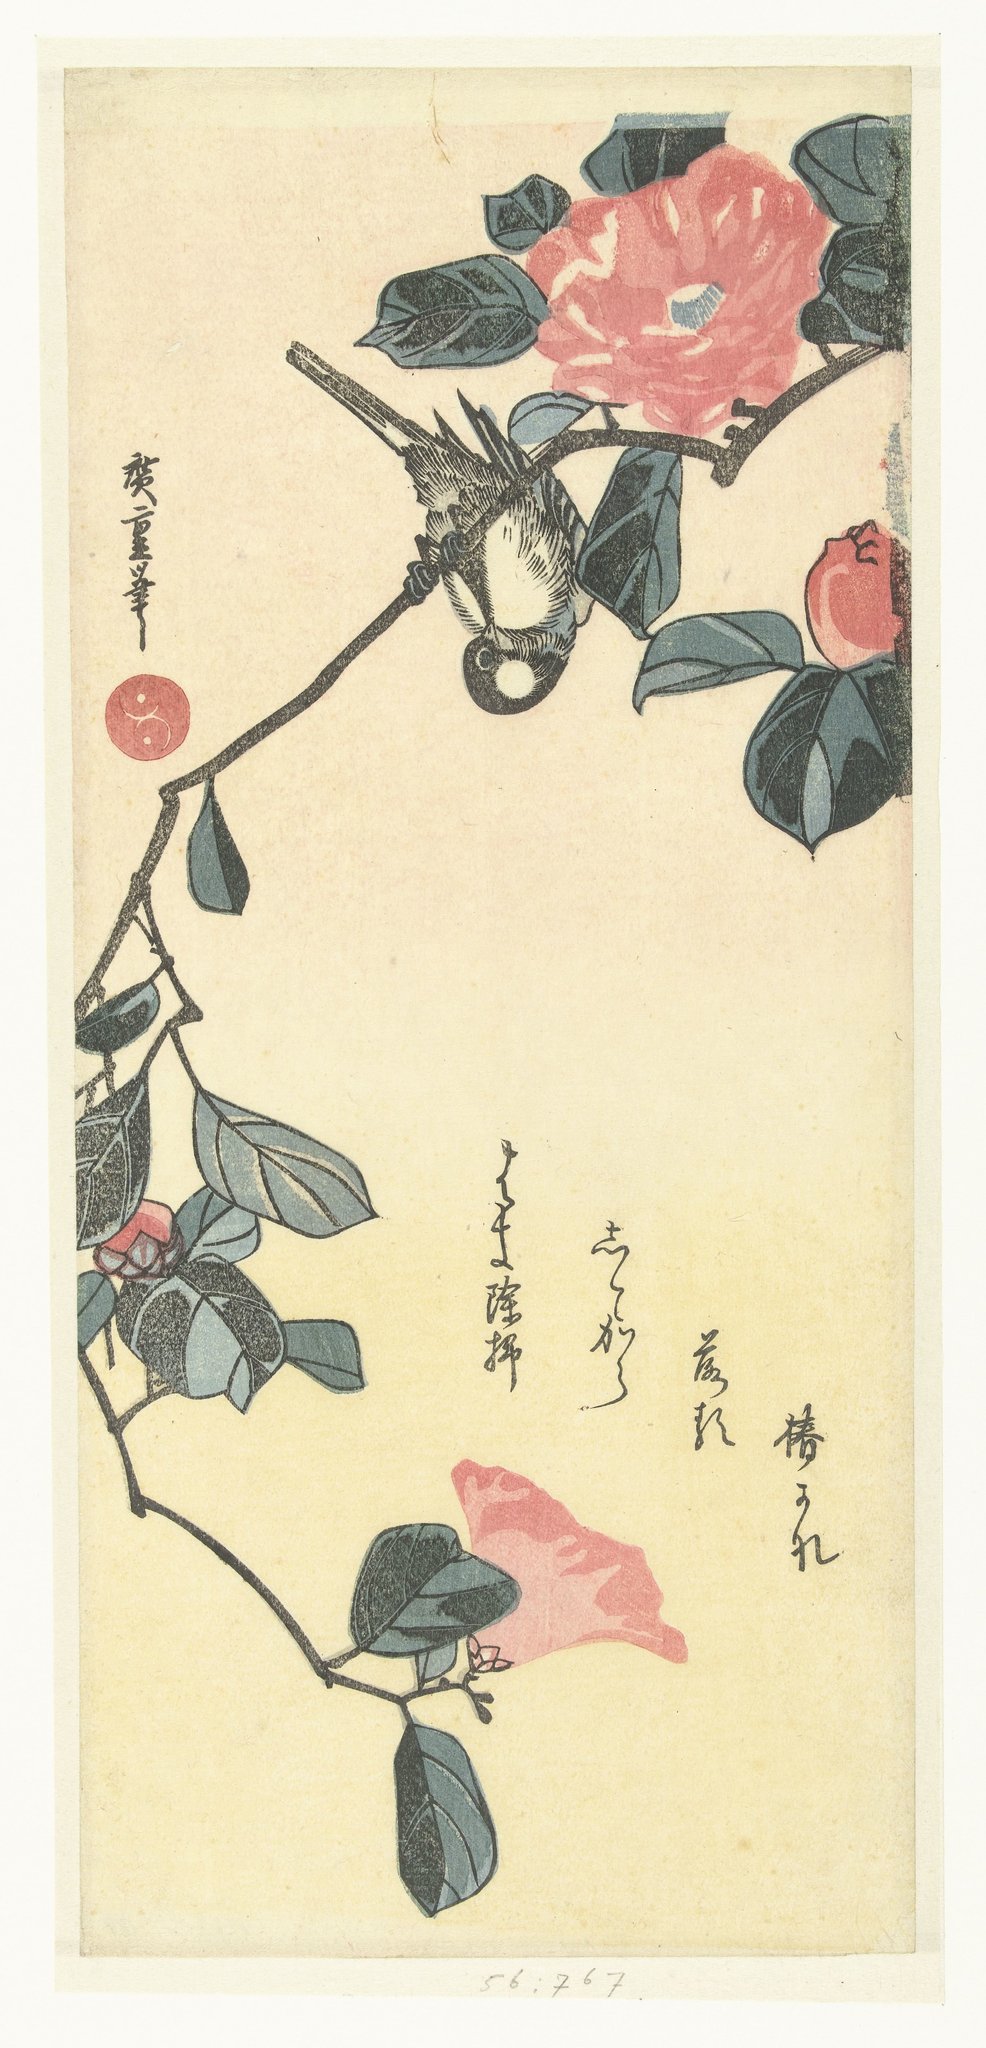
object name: print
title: Vogel en camelia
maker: utagawa hiroshige (i)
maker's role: draughtsman, print maker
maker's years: 1797-1858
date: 1850-1920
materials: paper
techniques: woodcut, nishiki e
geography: japan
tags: flowers, birds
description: Vogel, ondersteboven, op tak van bloeiende camelia; tegen gele achtergrond waarop gedicht.